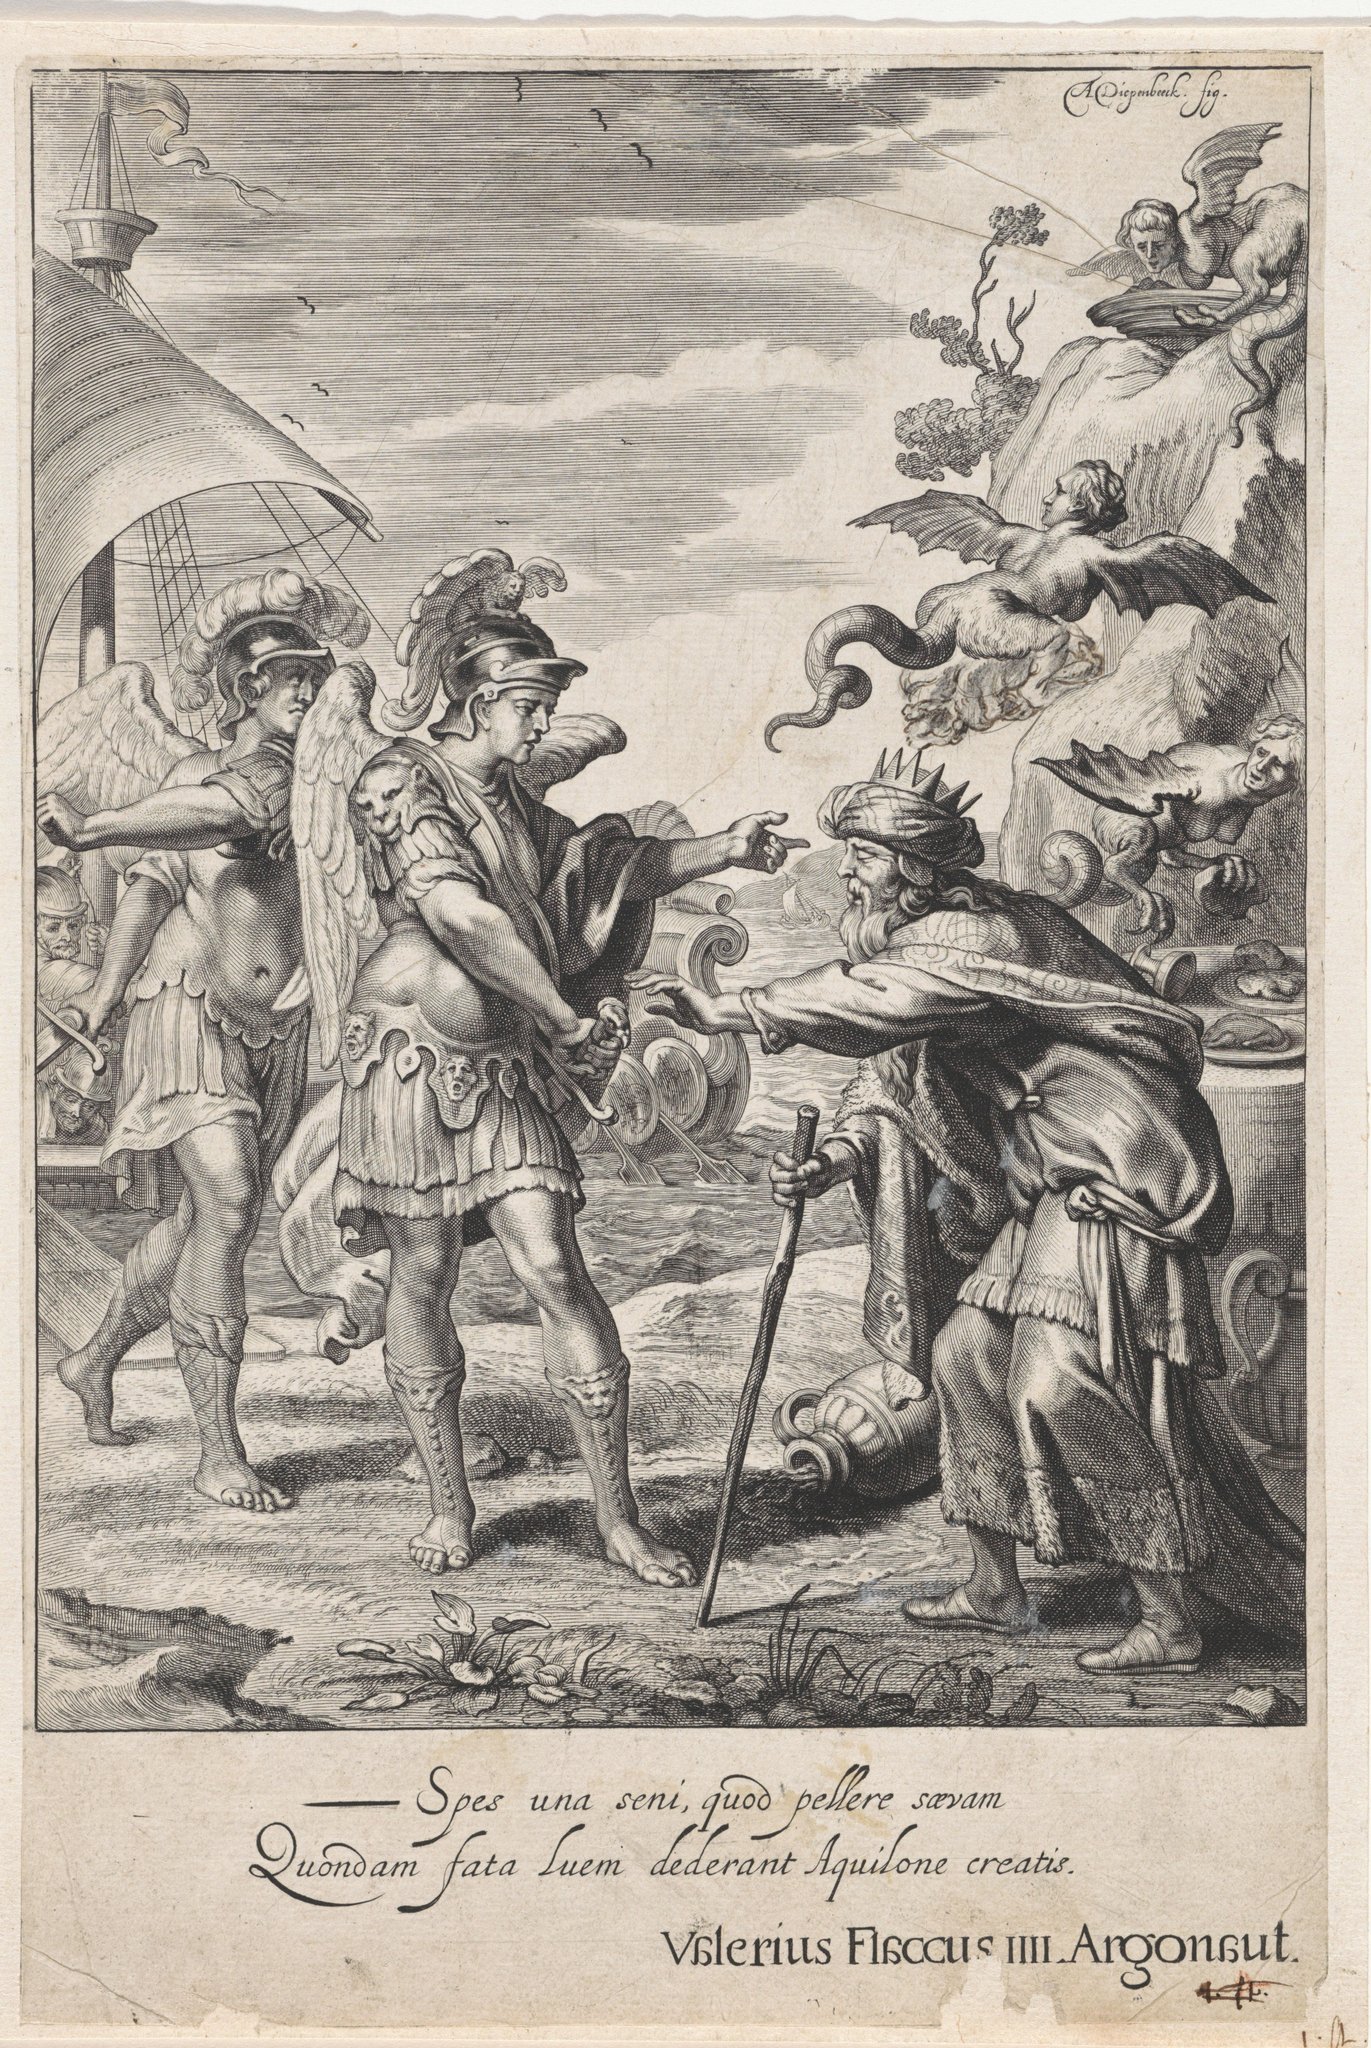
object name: book illustration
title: Calaïs en Zetes helpen Phineus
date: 1655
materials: paper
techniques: engraving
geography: southern netherlands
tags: calais and zetes chase away the harpies that plagued phineus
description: Het schip met de Argonauten is aangekomen in het koninkrijk van Phineus, wiens eten voortdurend door drie Harpijen wordt gestolen. De twee zonen van Boreas, Calaïs en Zetes, staan met getrokken zwaarden voor de blinde Phineus. Ze staan op het punt om de Harpijen te achtervolgen. In de marge een tweeregelig onderschrift in het Latijn.